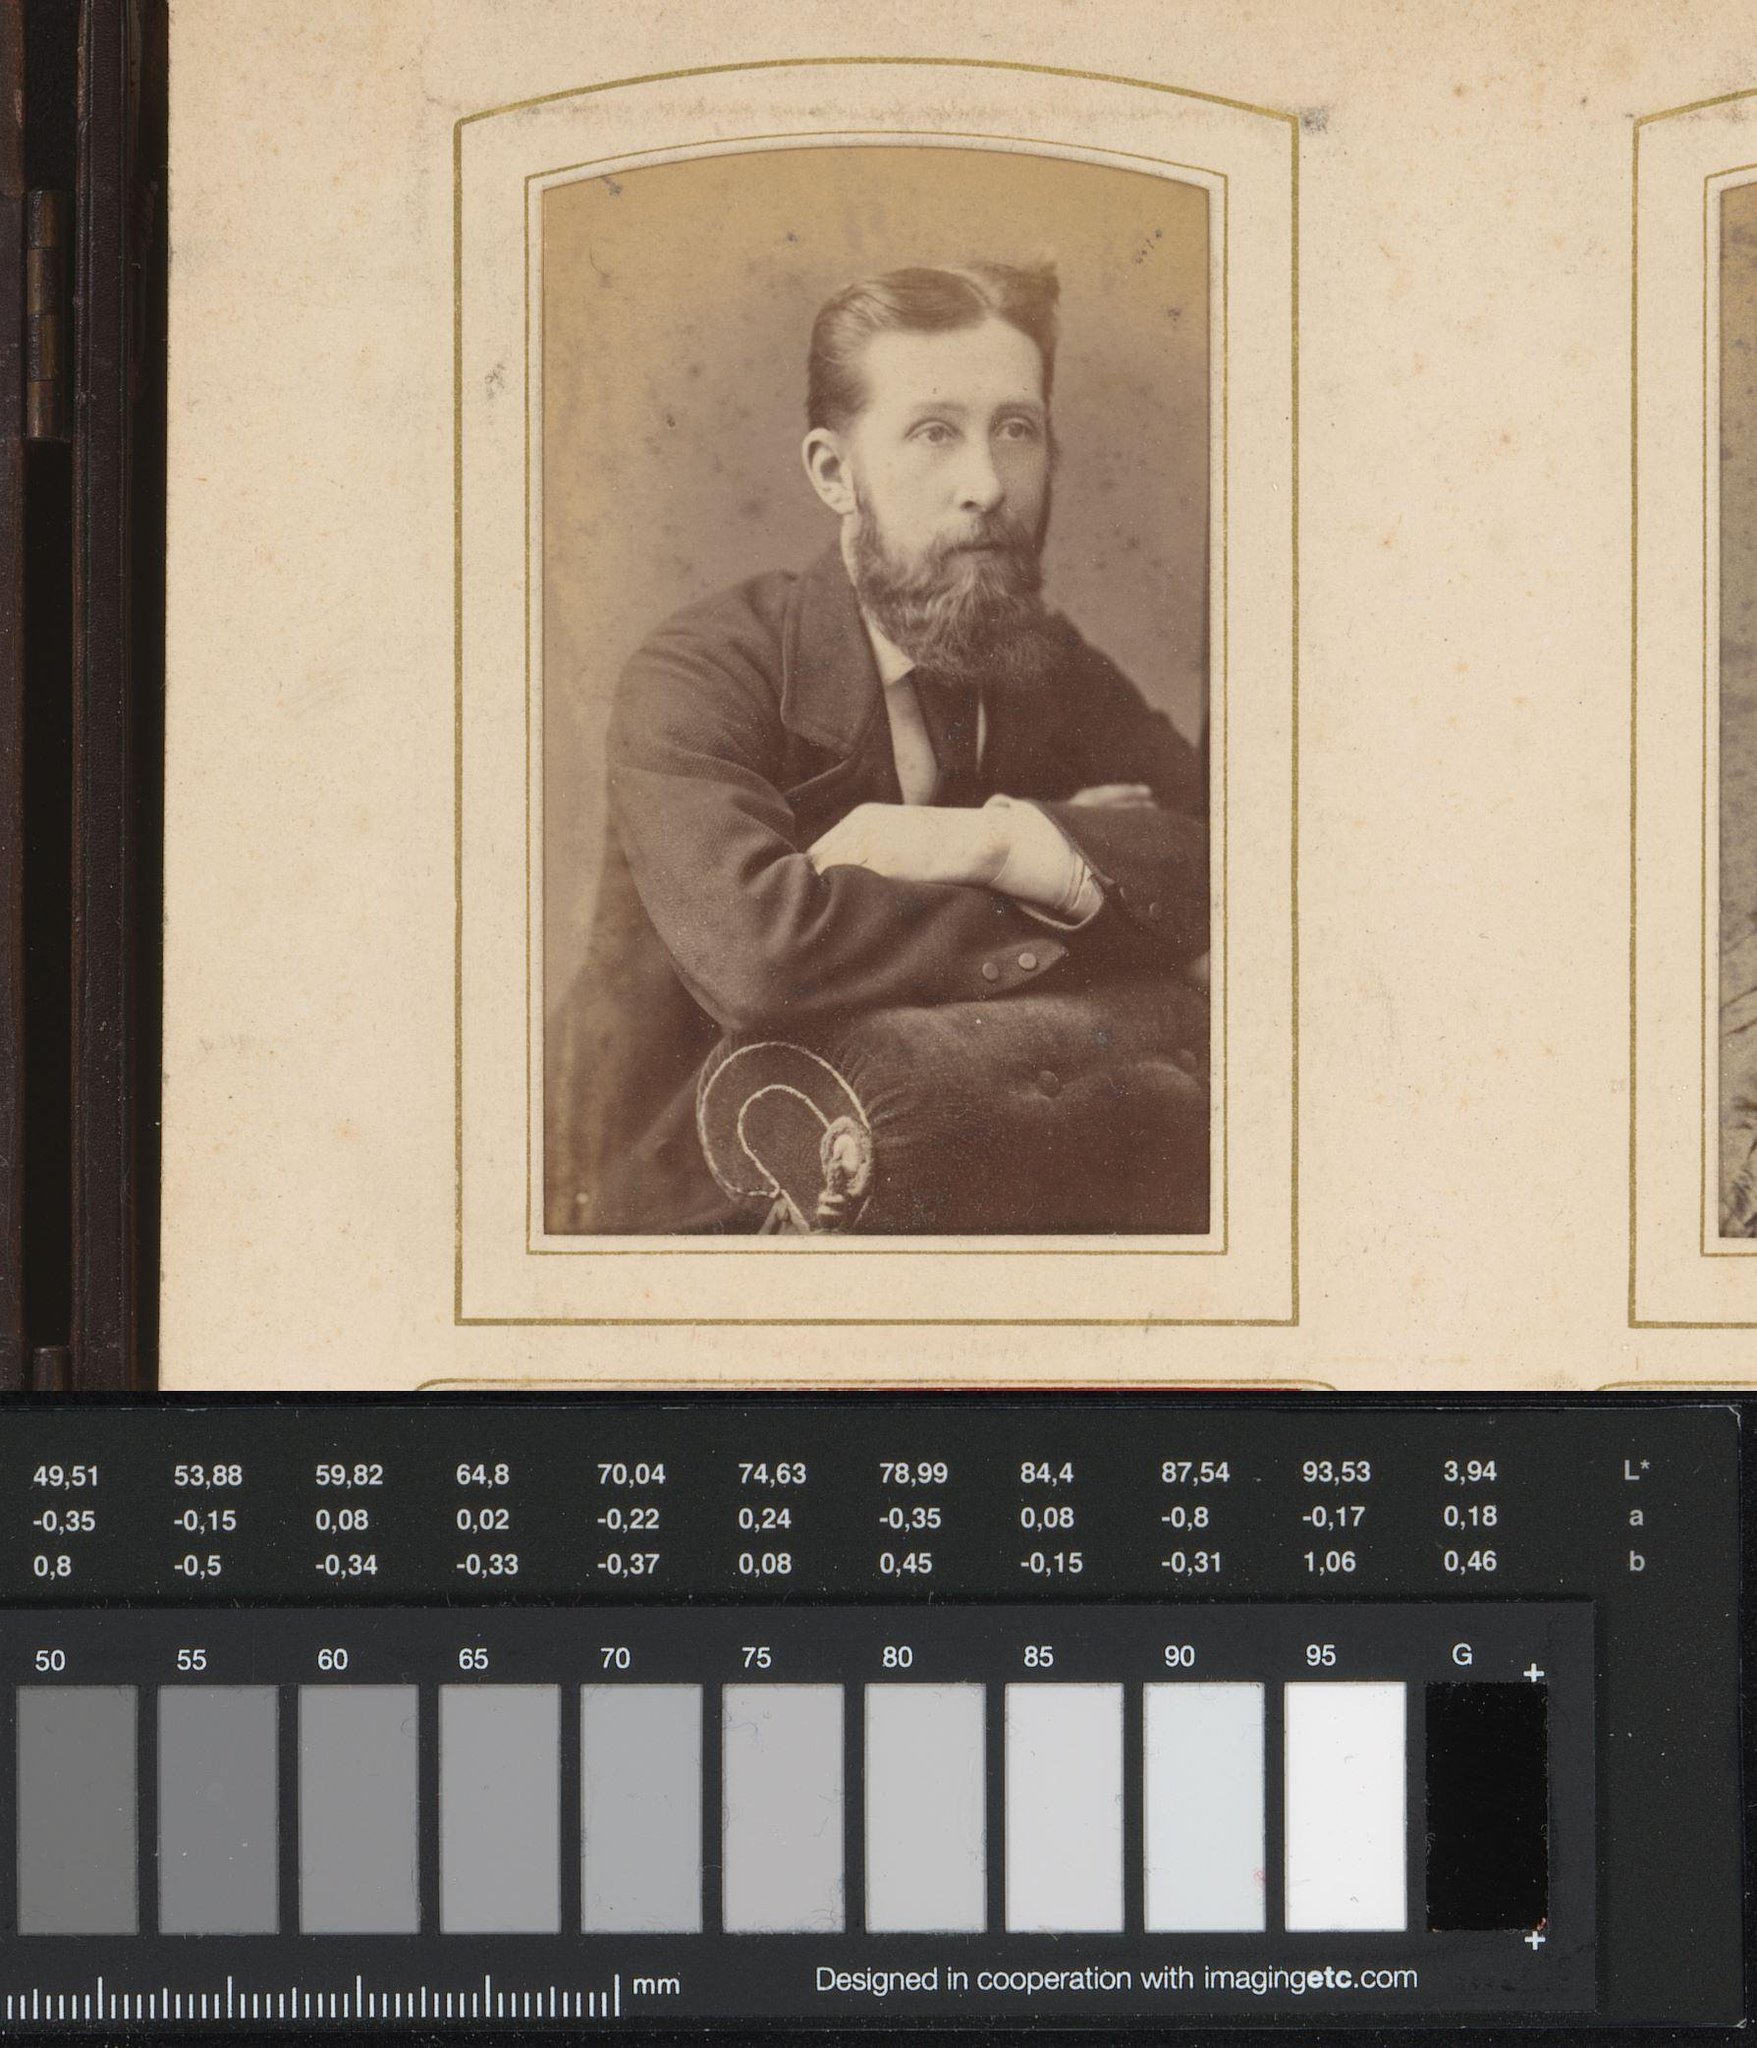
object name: album leaf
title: Portret van een man, leunend op een fauteuil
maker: a.d. lewis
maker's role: fotograaf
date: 1870-1880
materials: cardboard, photographic support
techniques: albumen print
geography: newcastle upon tyne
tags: historical persons, leaning figure, chair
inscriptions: inscription: ‘Newcastle-on-Tyne, 111 and 113 Scotswood Road; Tynemouth, 56 Front Street’